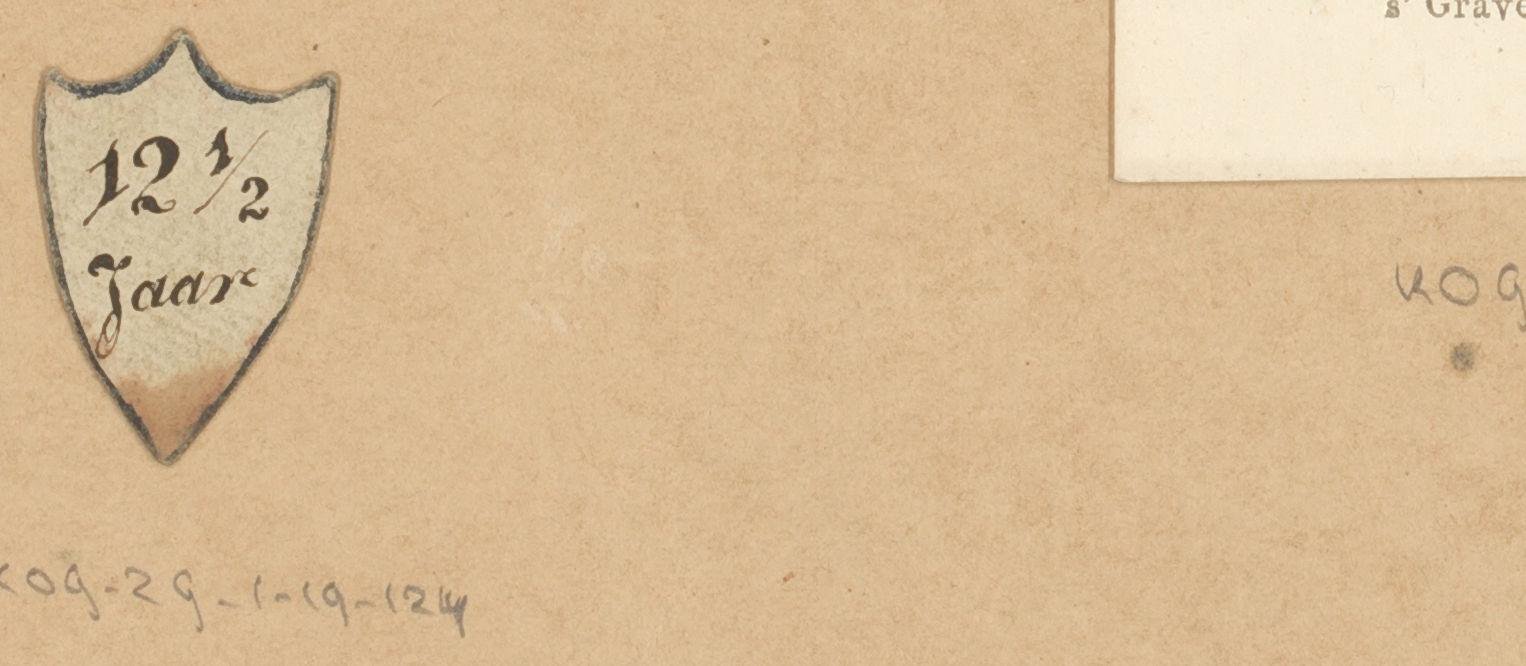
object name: drawing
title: Schildje huwelijksjubileum 12½ jaar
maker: Anonymous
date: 1830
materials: ink, paper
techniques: pen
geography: netherlands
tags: wedding feast, wedding meal, copper anniversary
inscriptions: collector's mark: Lugt 1641, collector's mark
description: Papieren schildje ter gelegenheid van een 12½ jaar koperen huwelijksjubileum, op 7 mei 1830. Waarschijnlijk gebruikt als decoratie op de tafel bij een feestmaal. Mogelijk onderdeel van een groep van bruilofts- en invitatiekaartjes van de families Bernard en Metayer. Onderwerpsrubrieken binnen de Atlas Zeden en Gewoonten: Des Menschen Begin, Midden en Einde. Bruiloft en huwelijk.